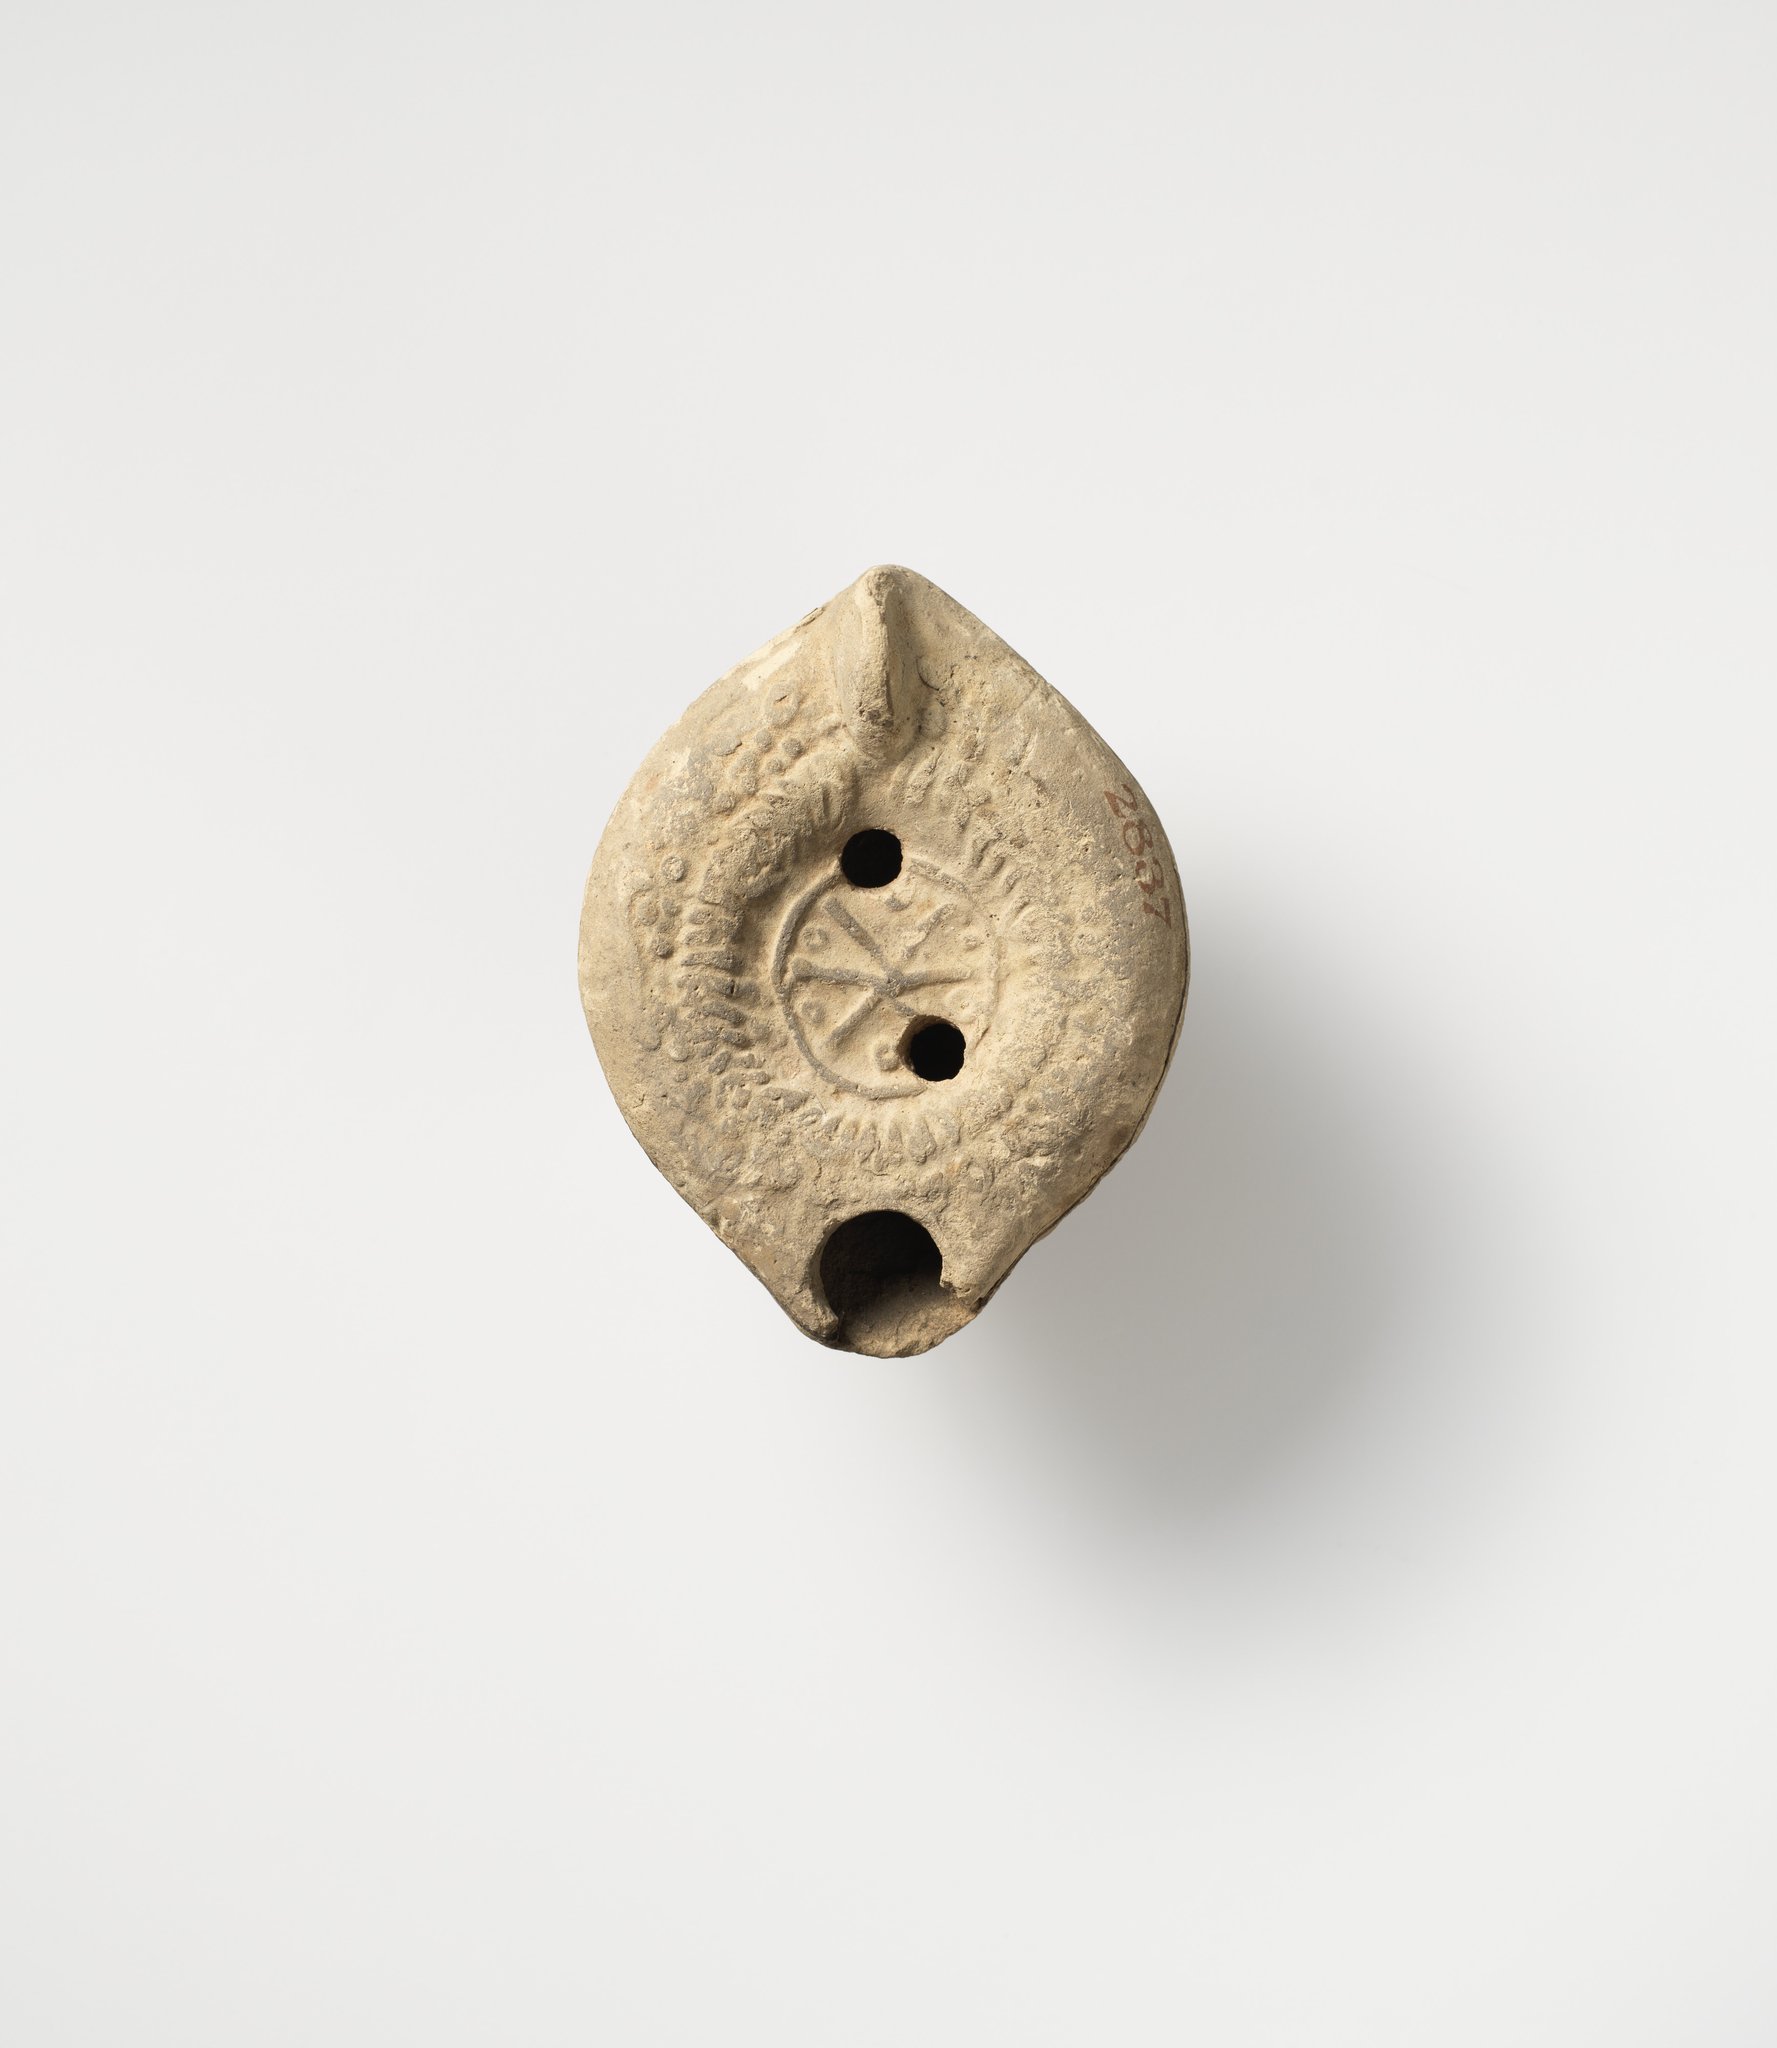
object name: lamp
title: Terracotta oil lamp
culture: roman, cypriot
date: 201-300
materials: terracotta